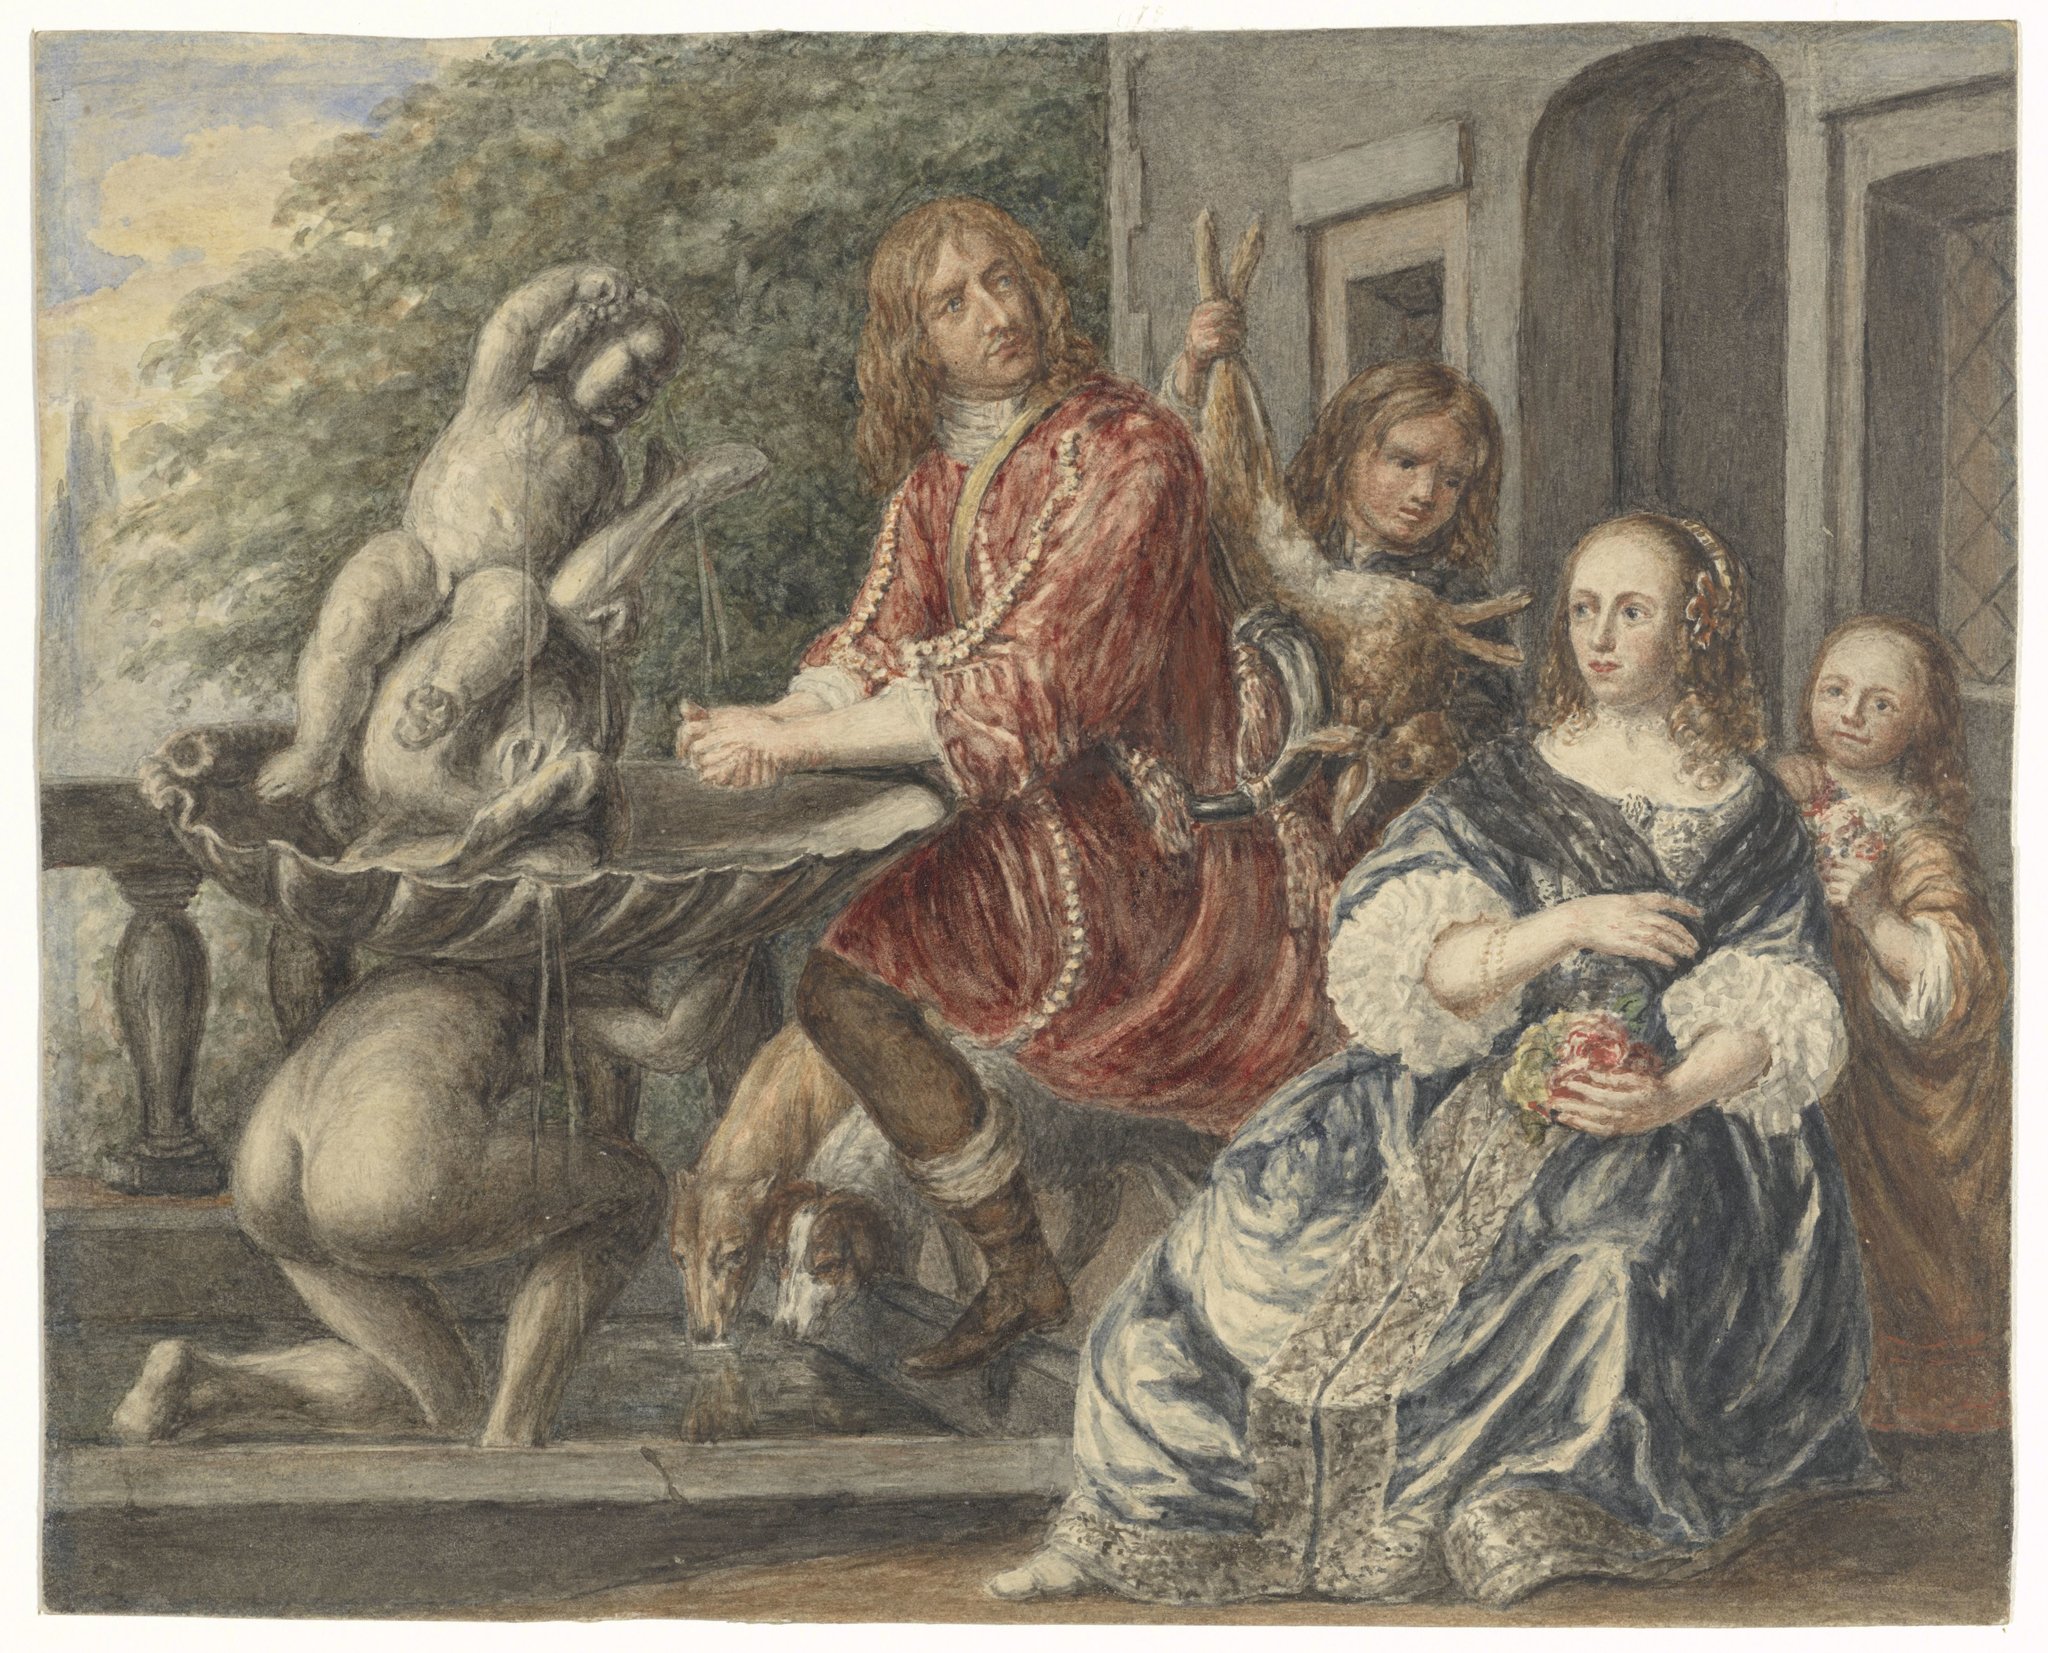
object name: drawing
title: Cornelis de Wit en zijn familie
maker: matthijs maris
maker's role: draughtsman, painter, print maker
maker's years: 1839-1917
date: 1849-1917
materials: paper, watercolor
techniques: brush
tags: dordrecht, the hague, cornelis de witt, historical persons